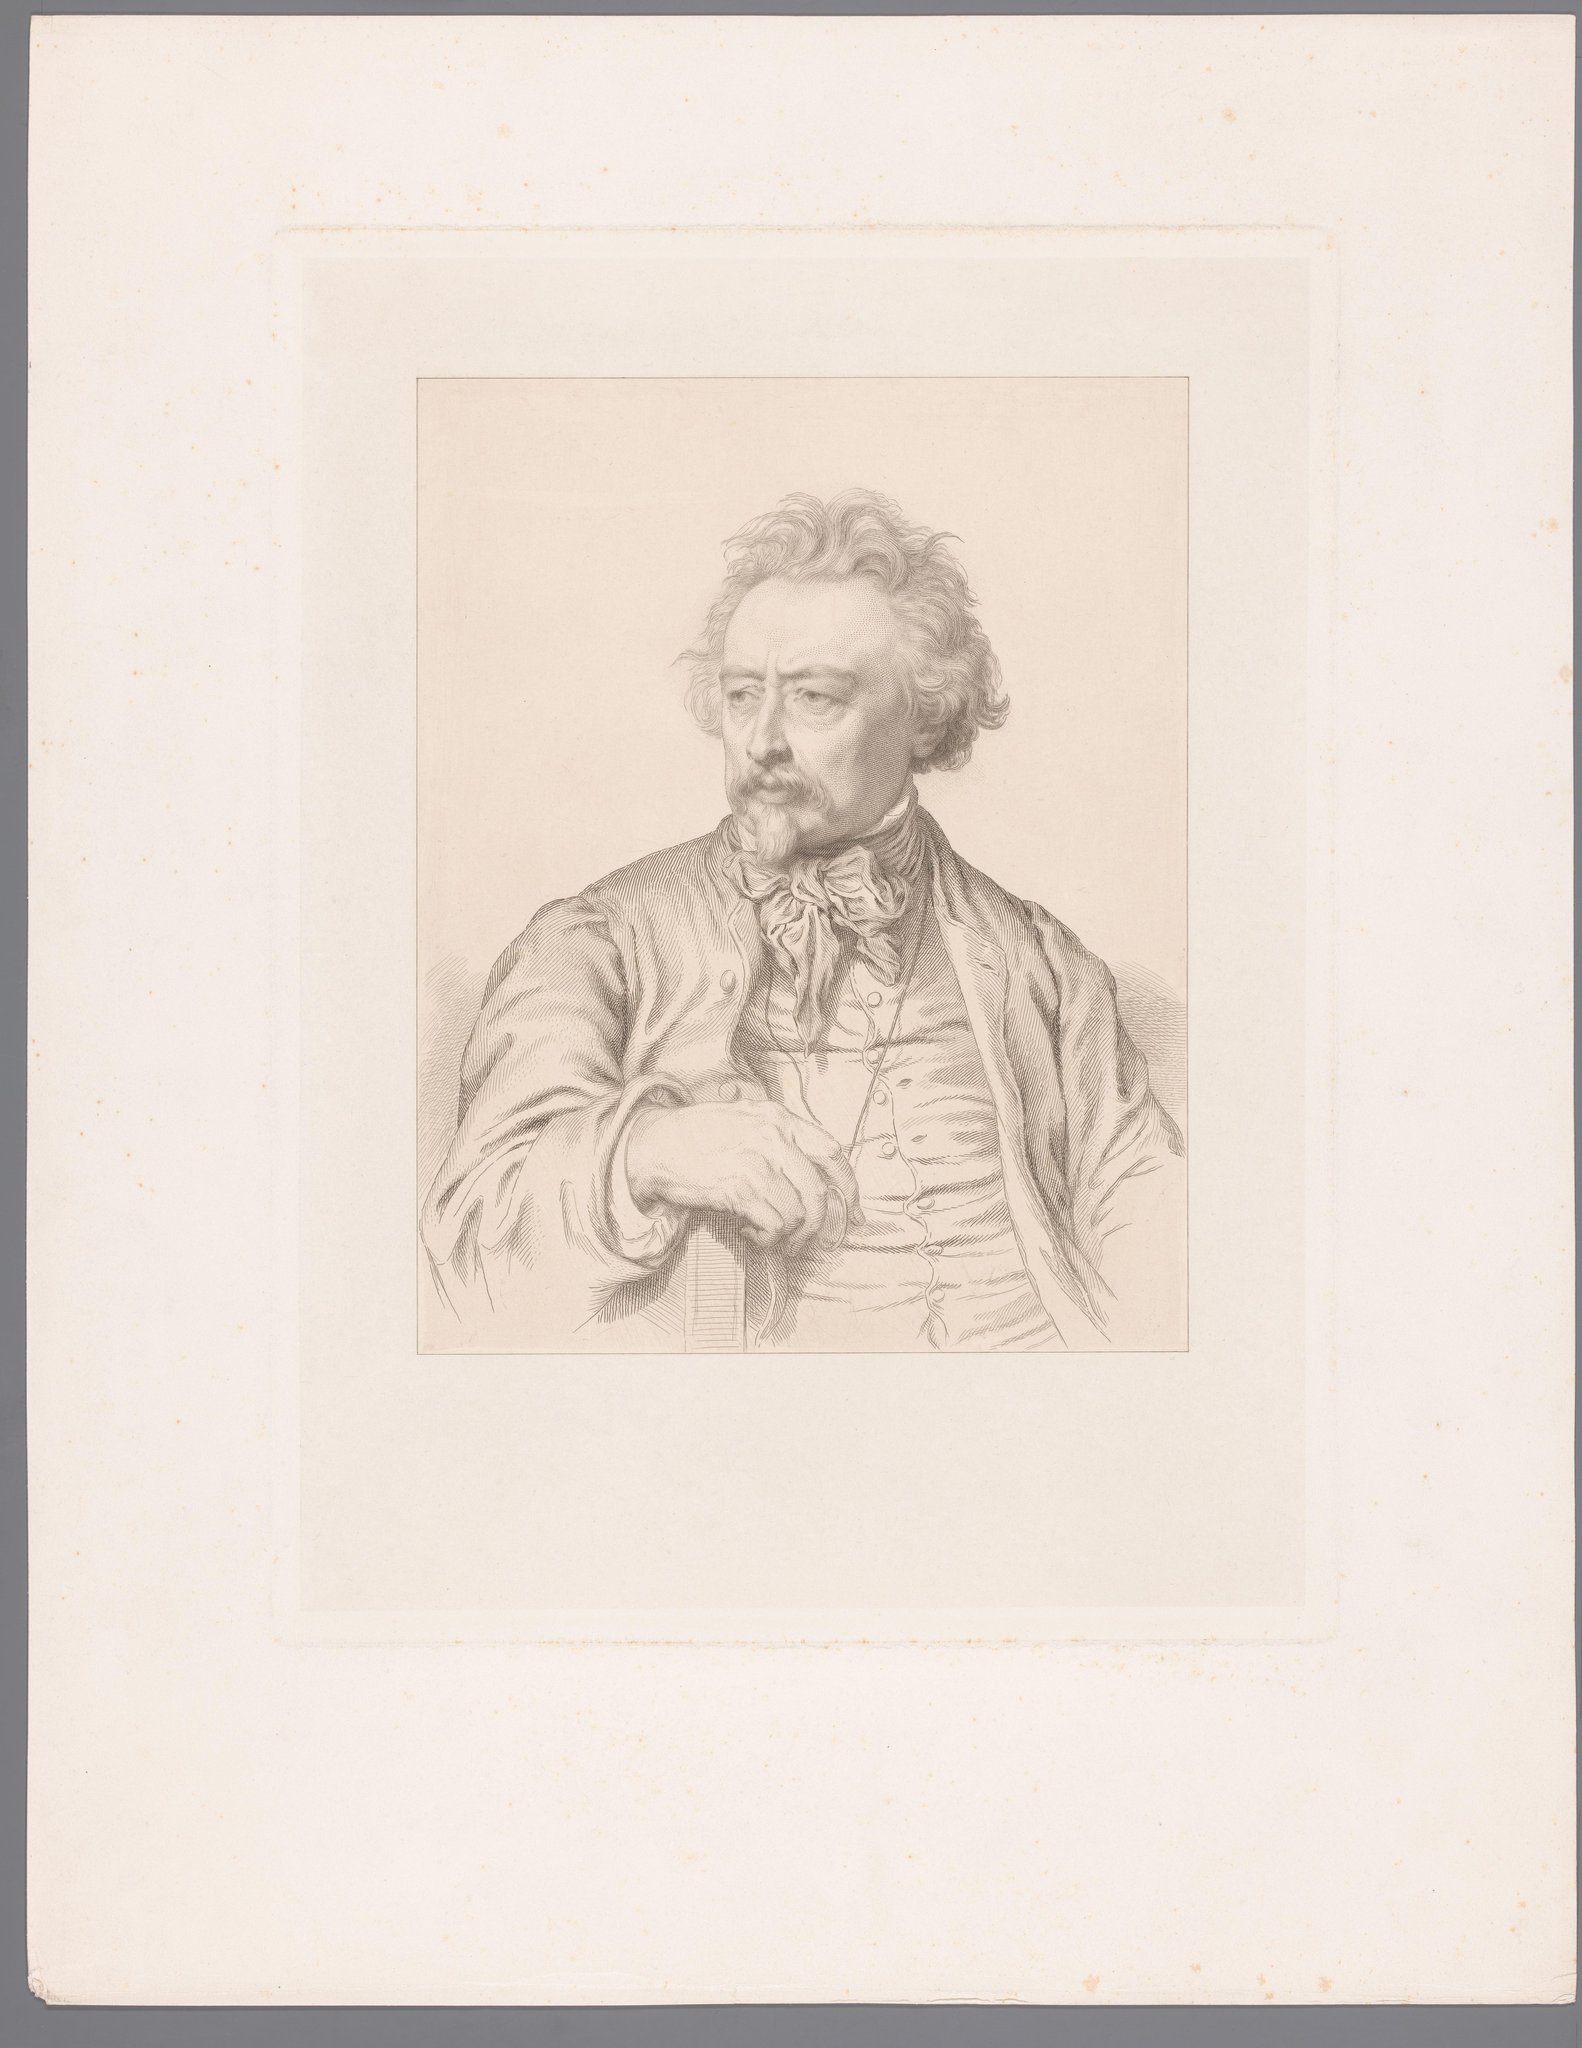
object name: print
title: Portret van Ary Scheffer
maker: louis pierre henriquel-dupont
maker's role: draughtsman, painter, print maker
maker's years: 1797-1892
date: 1858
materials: paper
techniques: etching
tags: ary scheffer, historical persons, portrait, self-portrait of artist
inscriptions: collector's mark: Lugt 2165